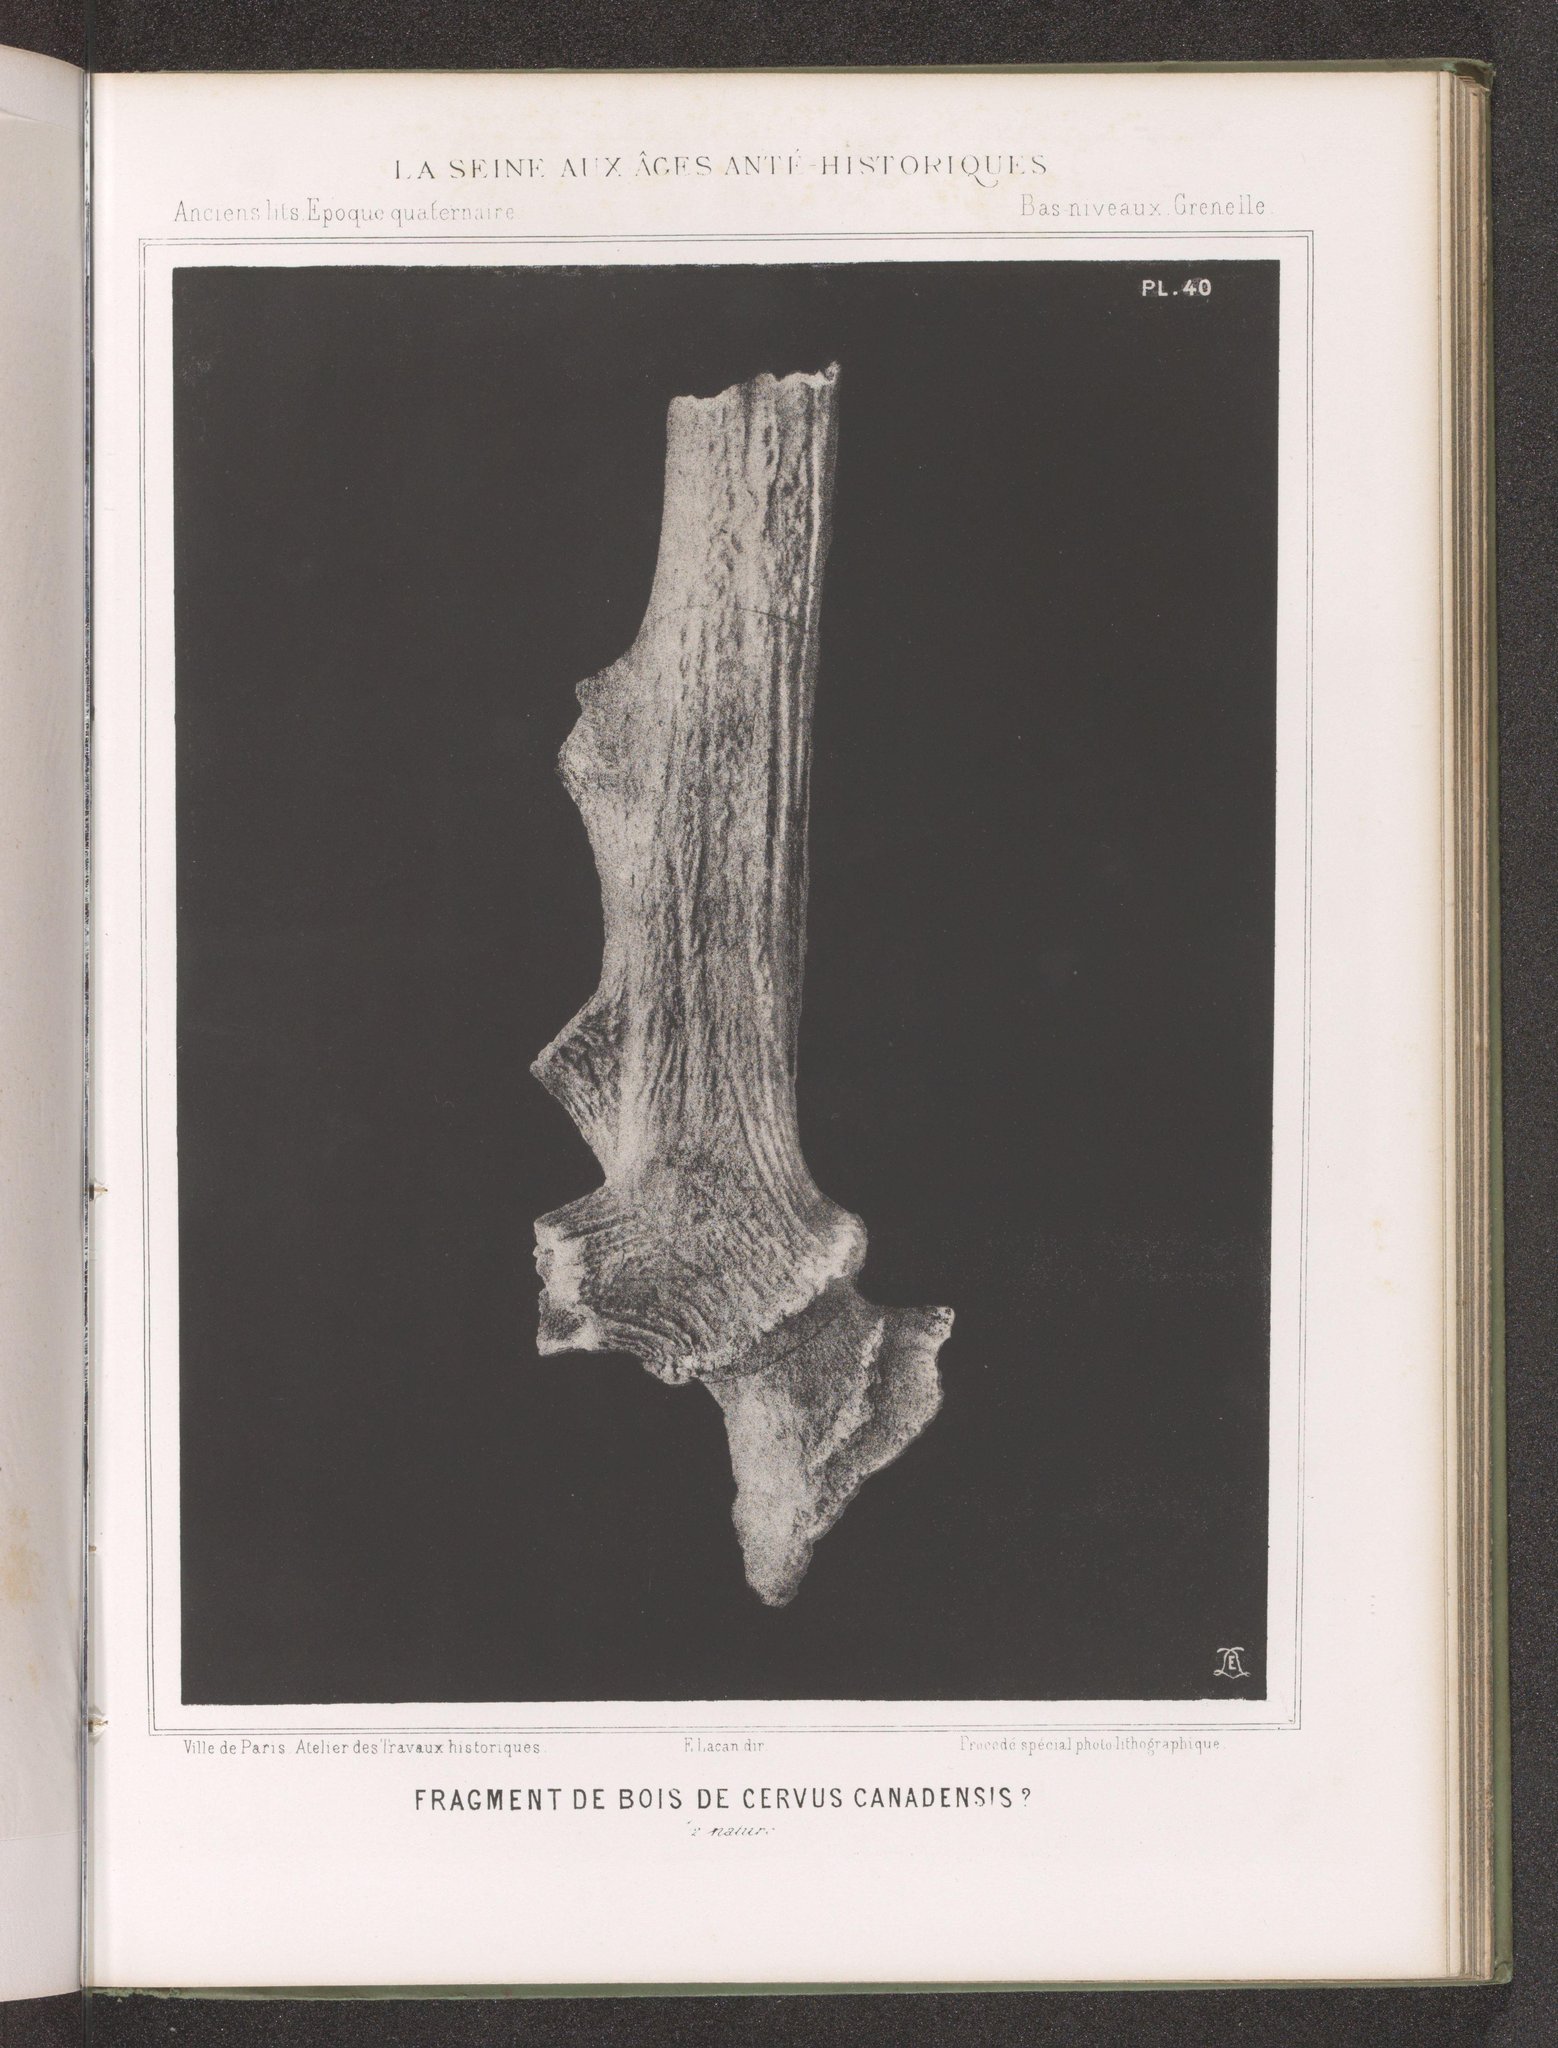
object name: page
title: Bot van een hert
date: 1860-1869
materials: paper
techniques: photolithography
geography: paris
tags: animals (+ skeleton of an animal), palaeontology, france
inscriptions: inscription: ‘Ville de Paris. Atelier des Travaux historiques E. Lacan, dir. Procédé spécial photo-lithographique.’, monogram: ‘LEL’, number: ‘Pl. 40’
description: Voor plek prent in boek: zie nummer onder 'Opschriften / Merken'.